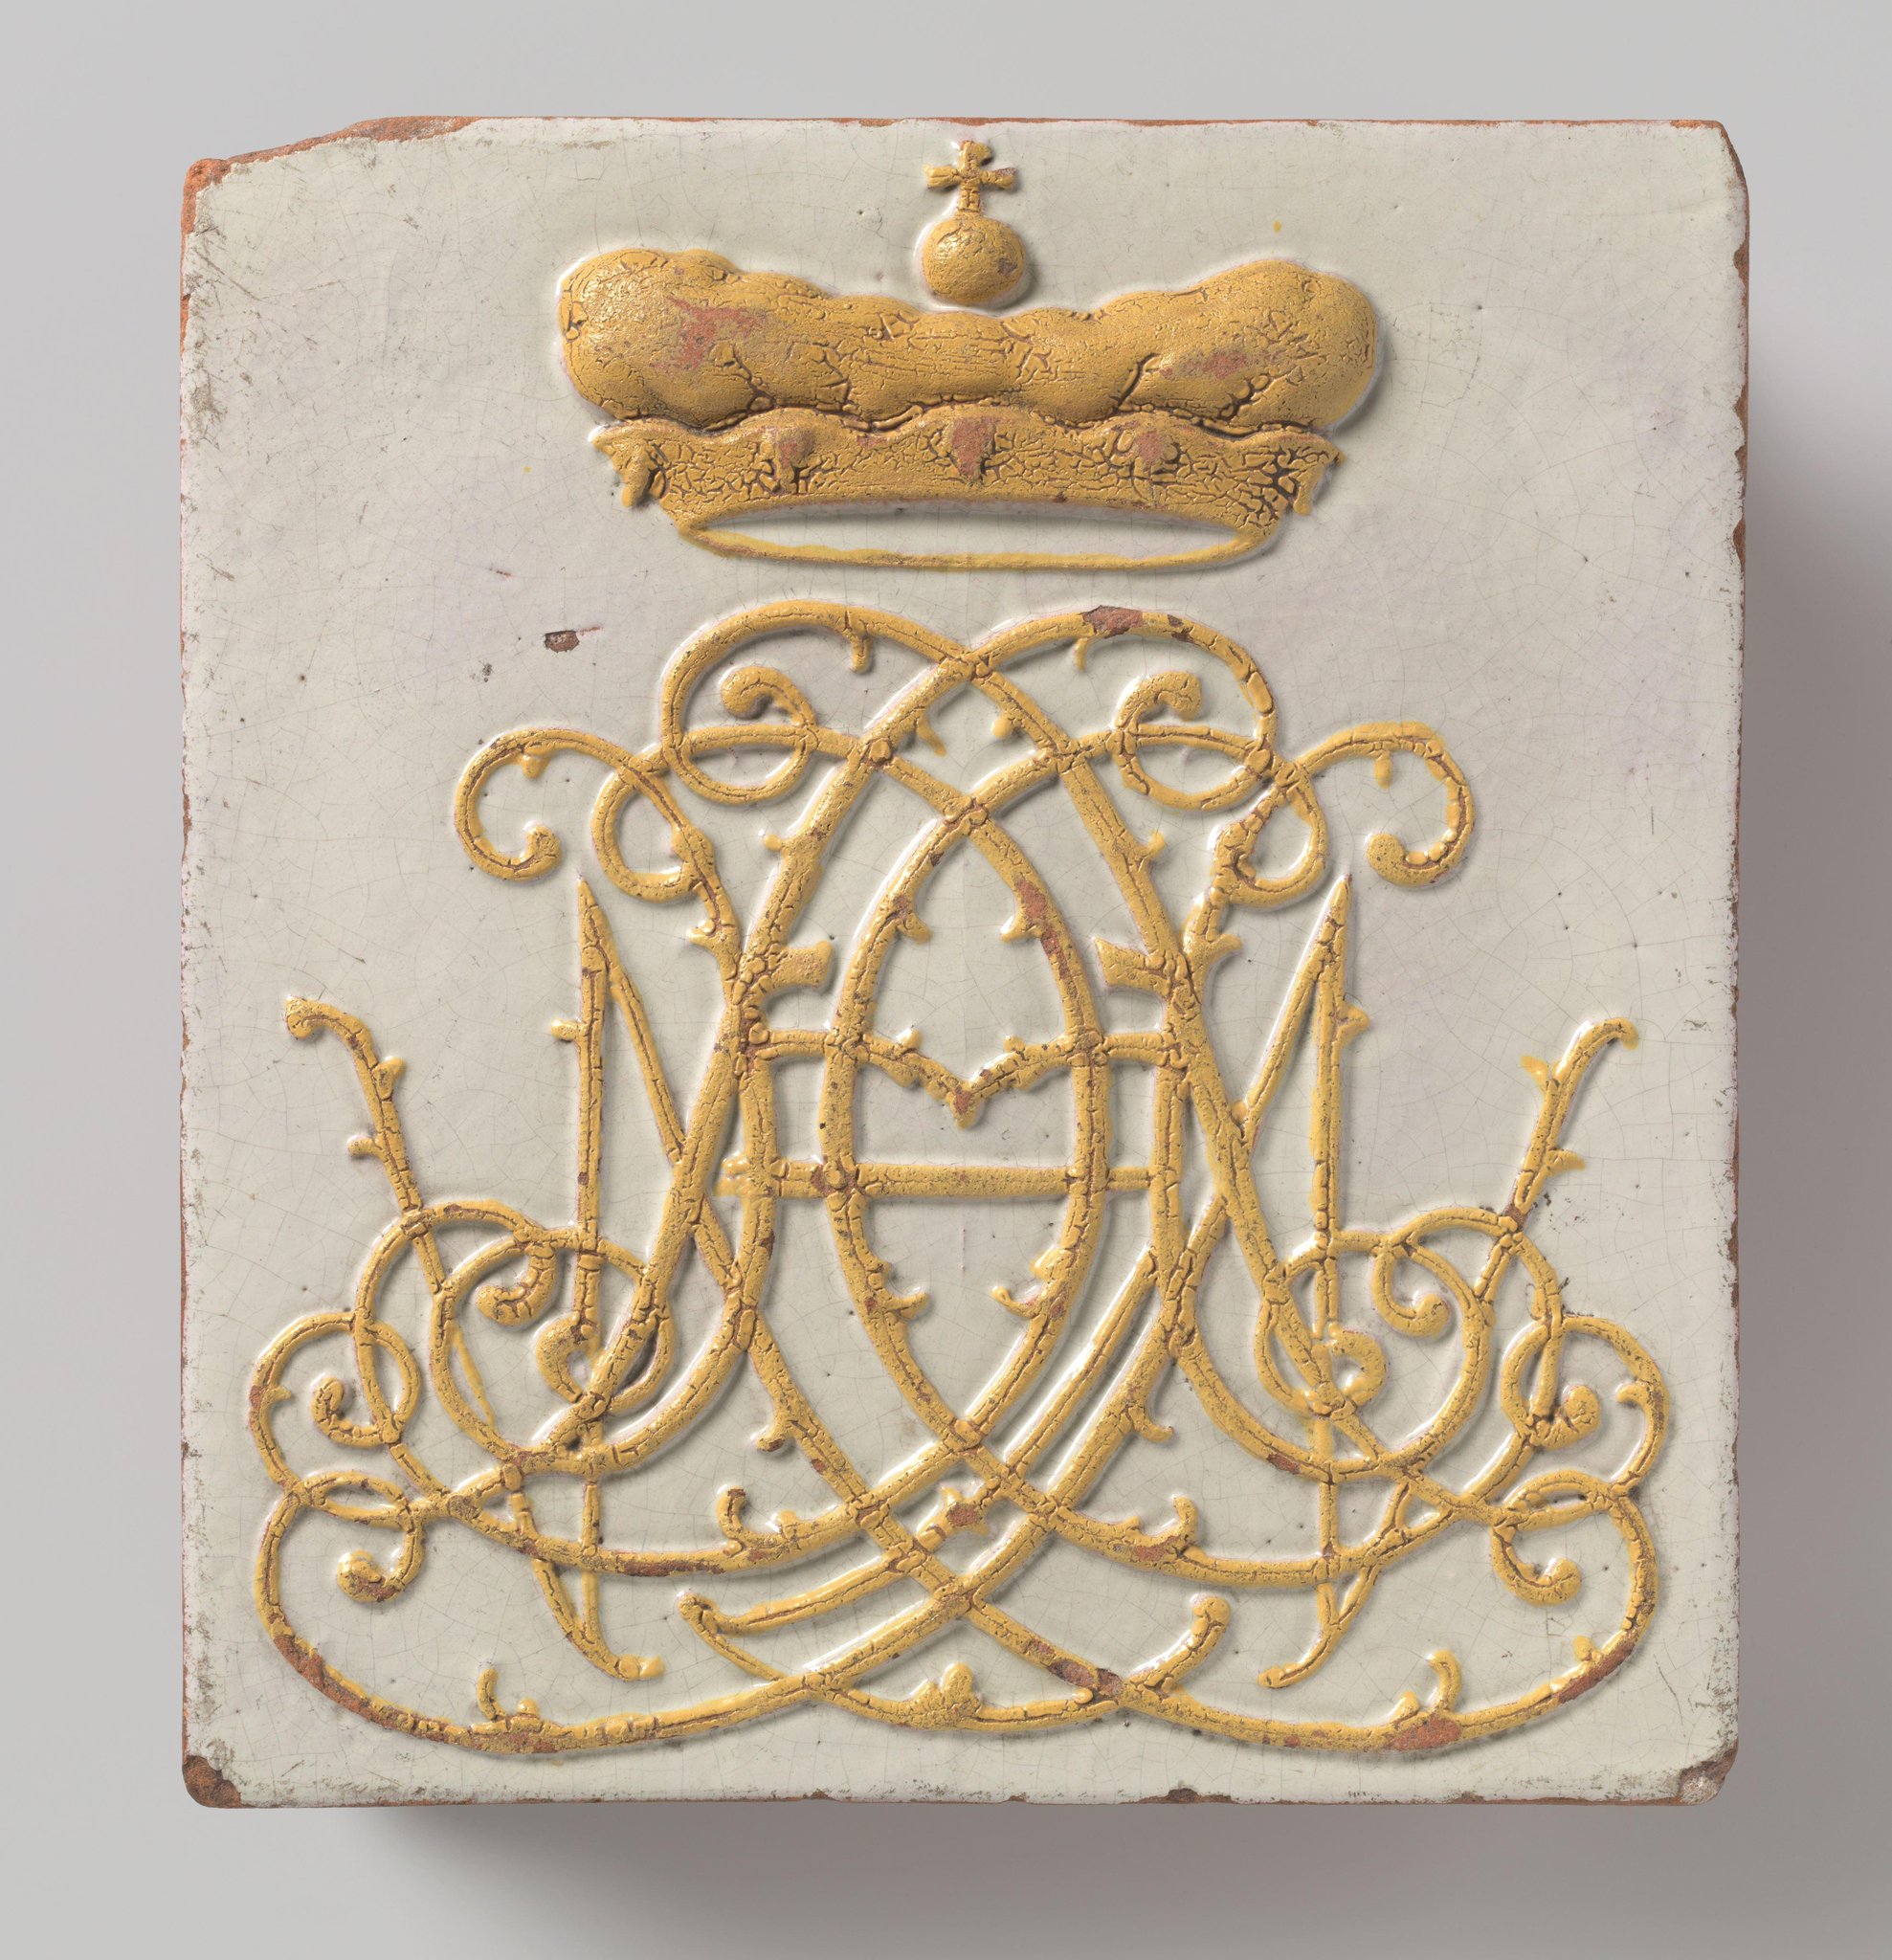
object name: tile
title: Tegel, wit geëmailleerde vierkant, waarop in geel dooreen gestrengelde naamletters, gekroond door een keurvorstelijke kroon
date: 1700-1800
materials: enamel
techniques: enameling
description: Tegel, wit geëmailleerde vierkant, waarop in geel dooreen gestrengelde naamletters, gekroond door een keurvorstelijke kroon.